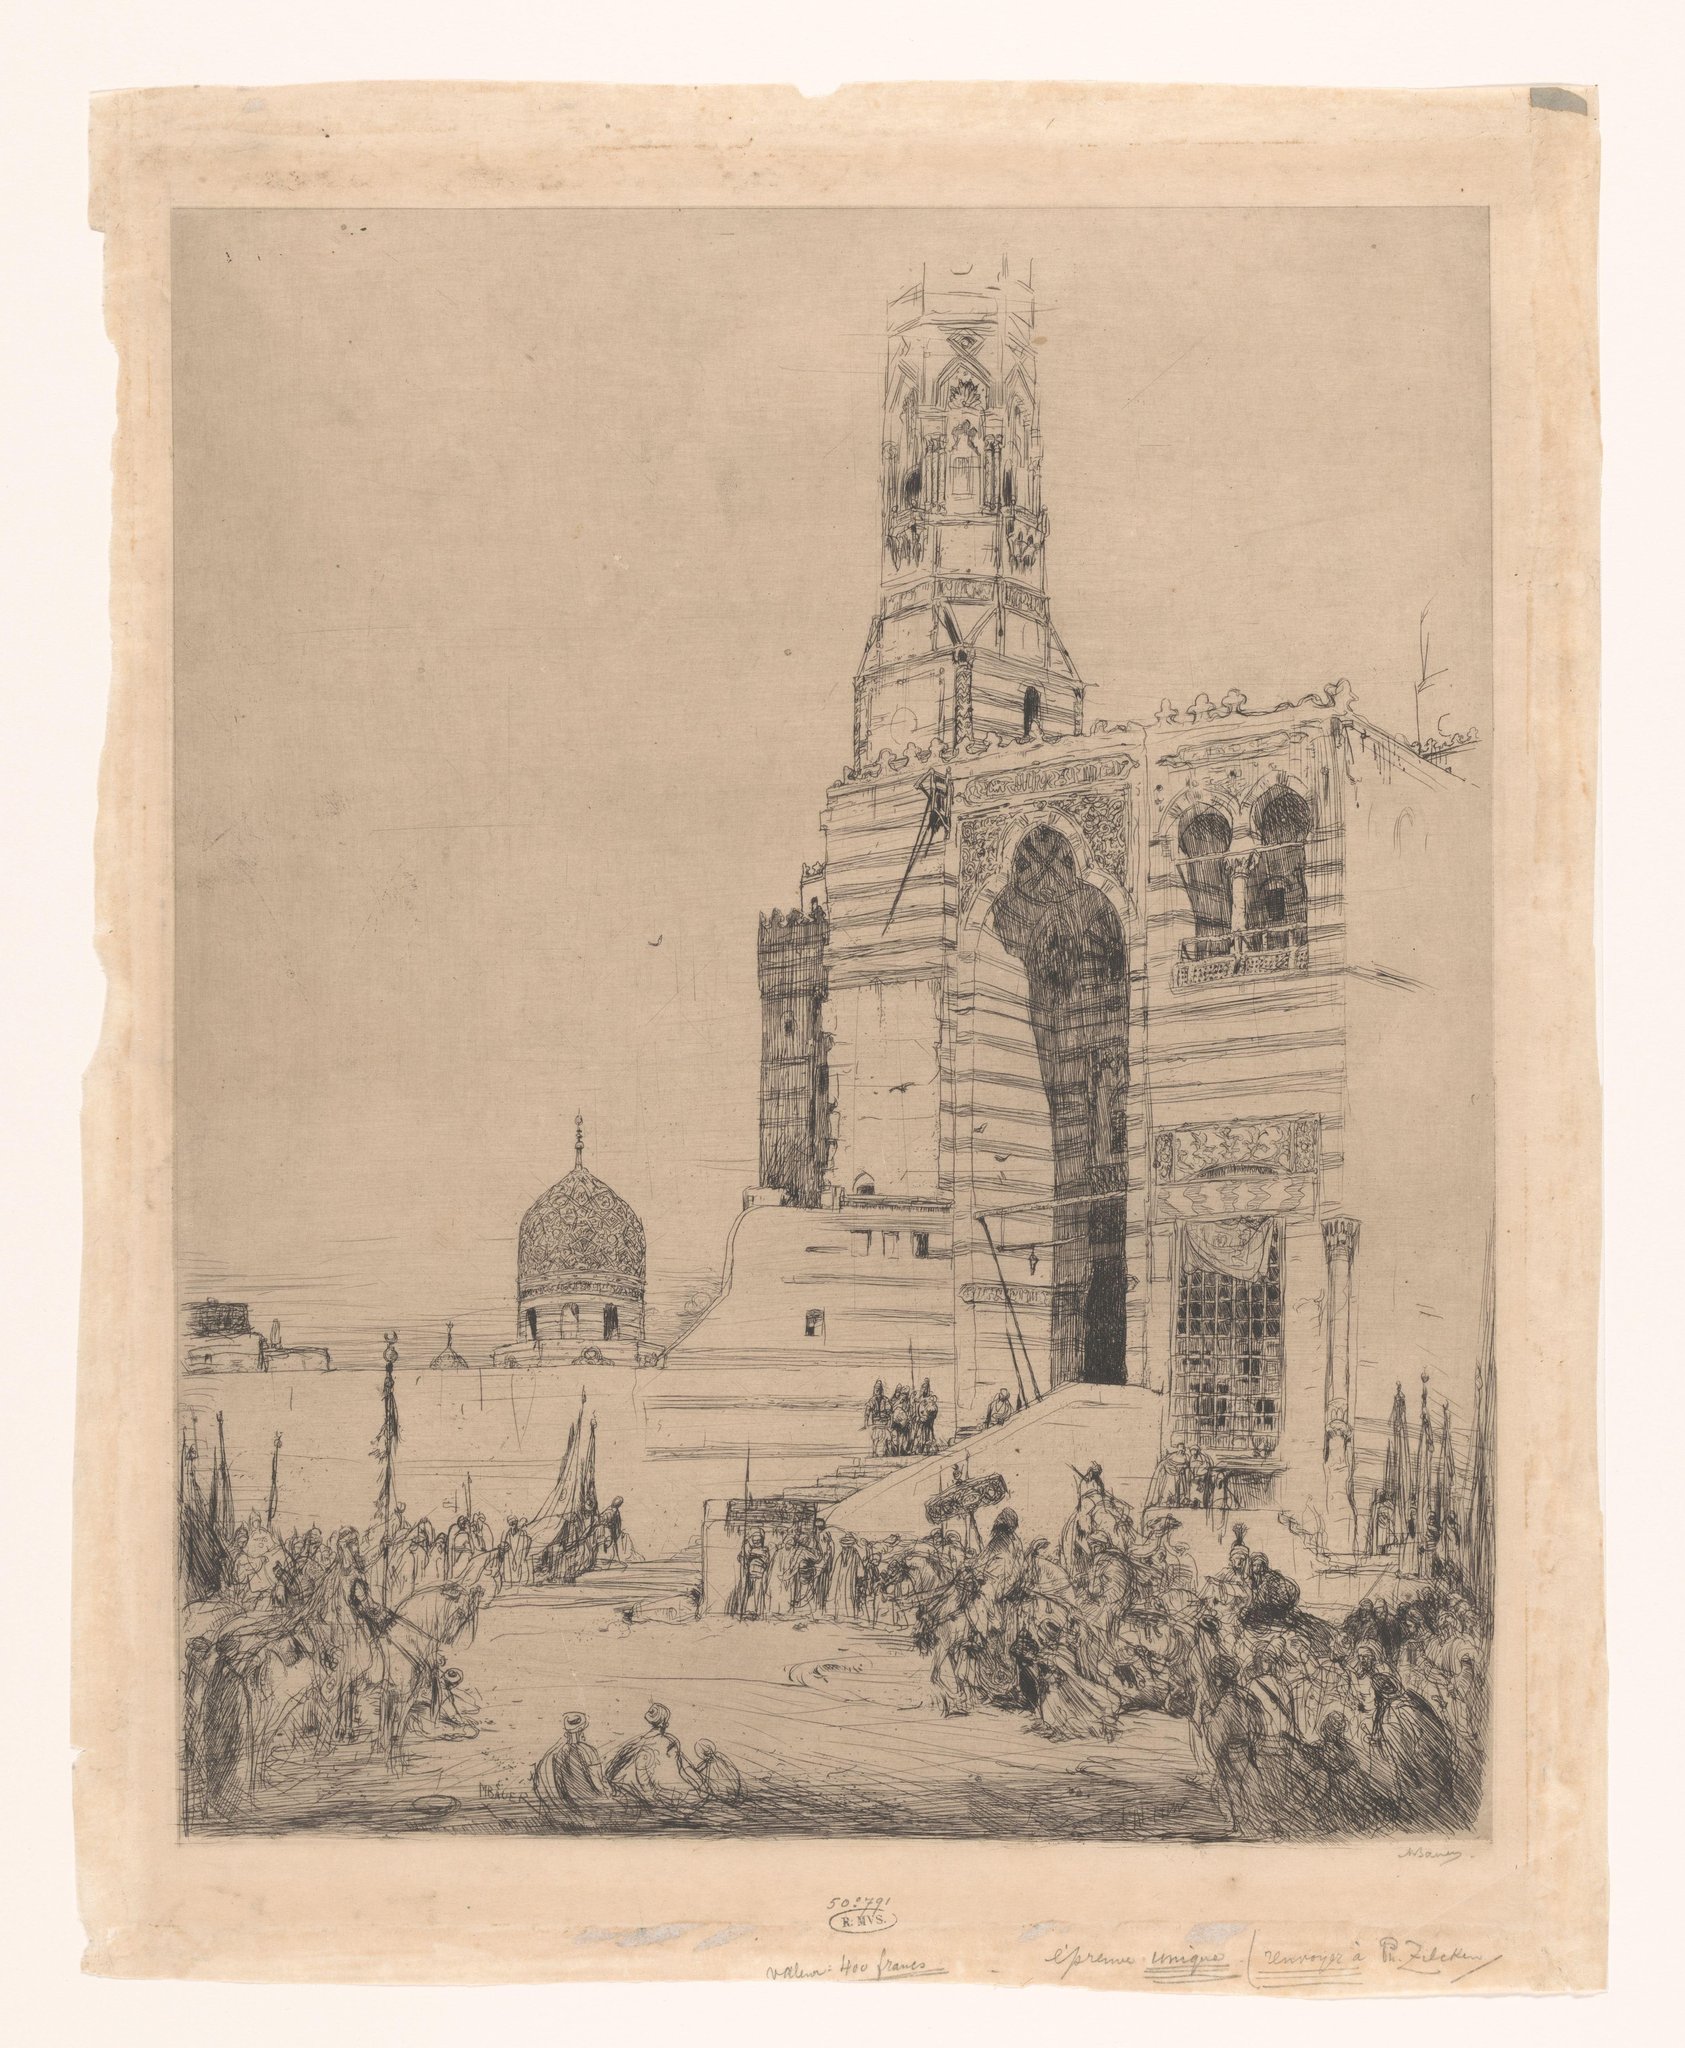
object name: print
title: Moskee en mausoleum van sultan al-Ashraf Qaitbey in Cairo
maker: marius bauer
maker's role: draughtsman, print maker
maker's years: 1867-1932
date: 1894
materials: paper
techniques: etching, intaglio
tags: city dwellers, mausoleum, temple, shrine ~ islam, mohammedanism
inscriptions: inscription: ‘épreuve unique. renvoye à Ph. Zilcken’, inscription: ‘valeur: 400 francs’, collector's mark: Lugt 2228